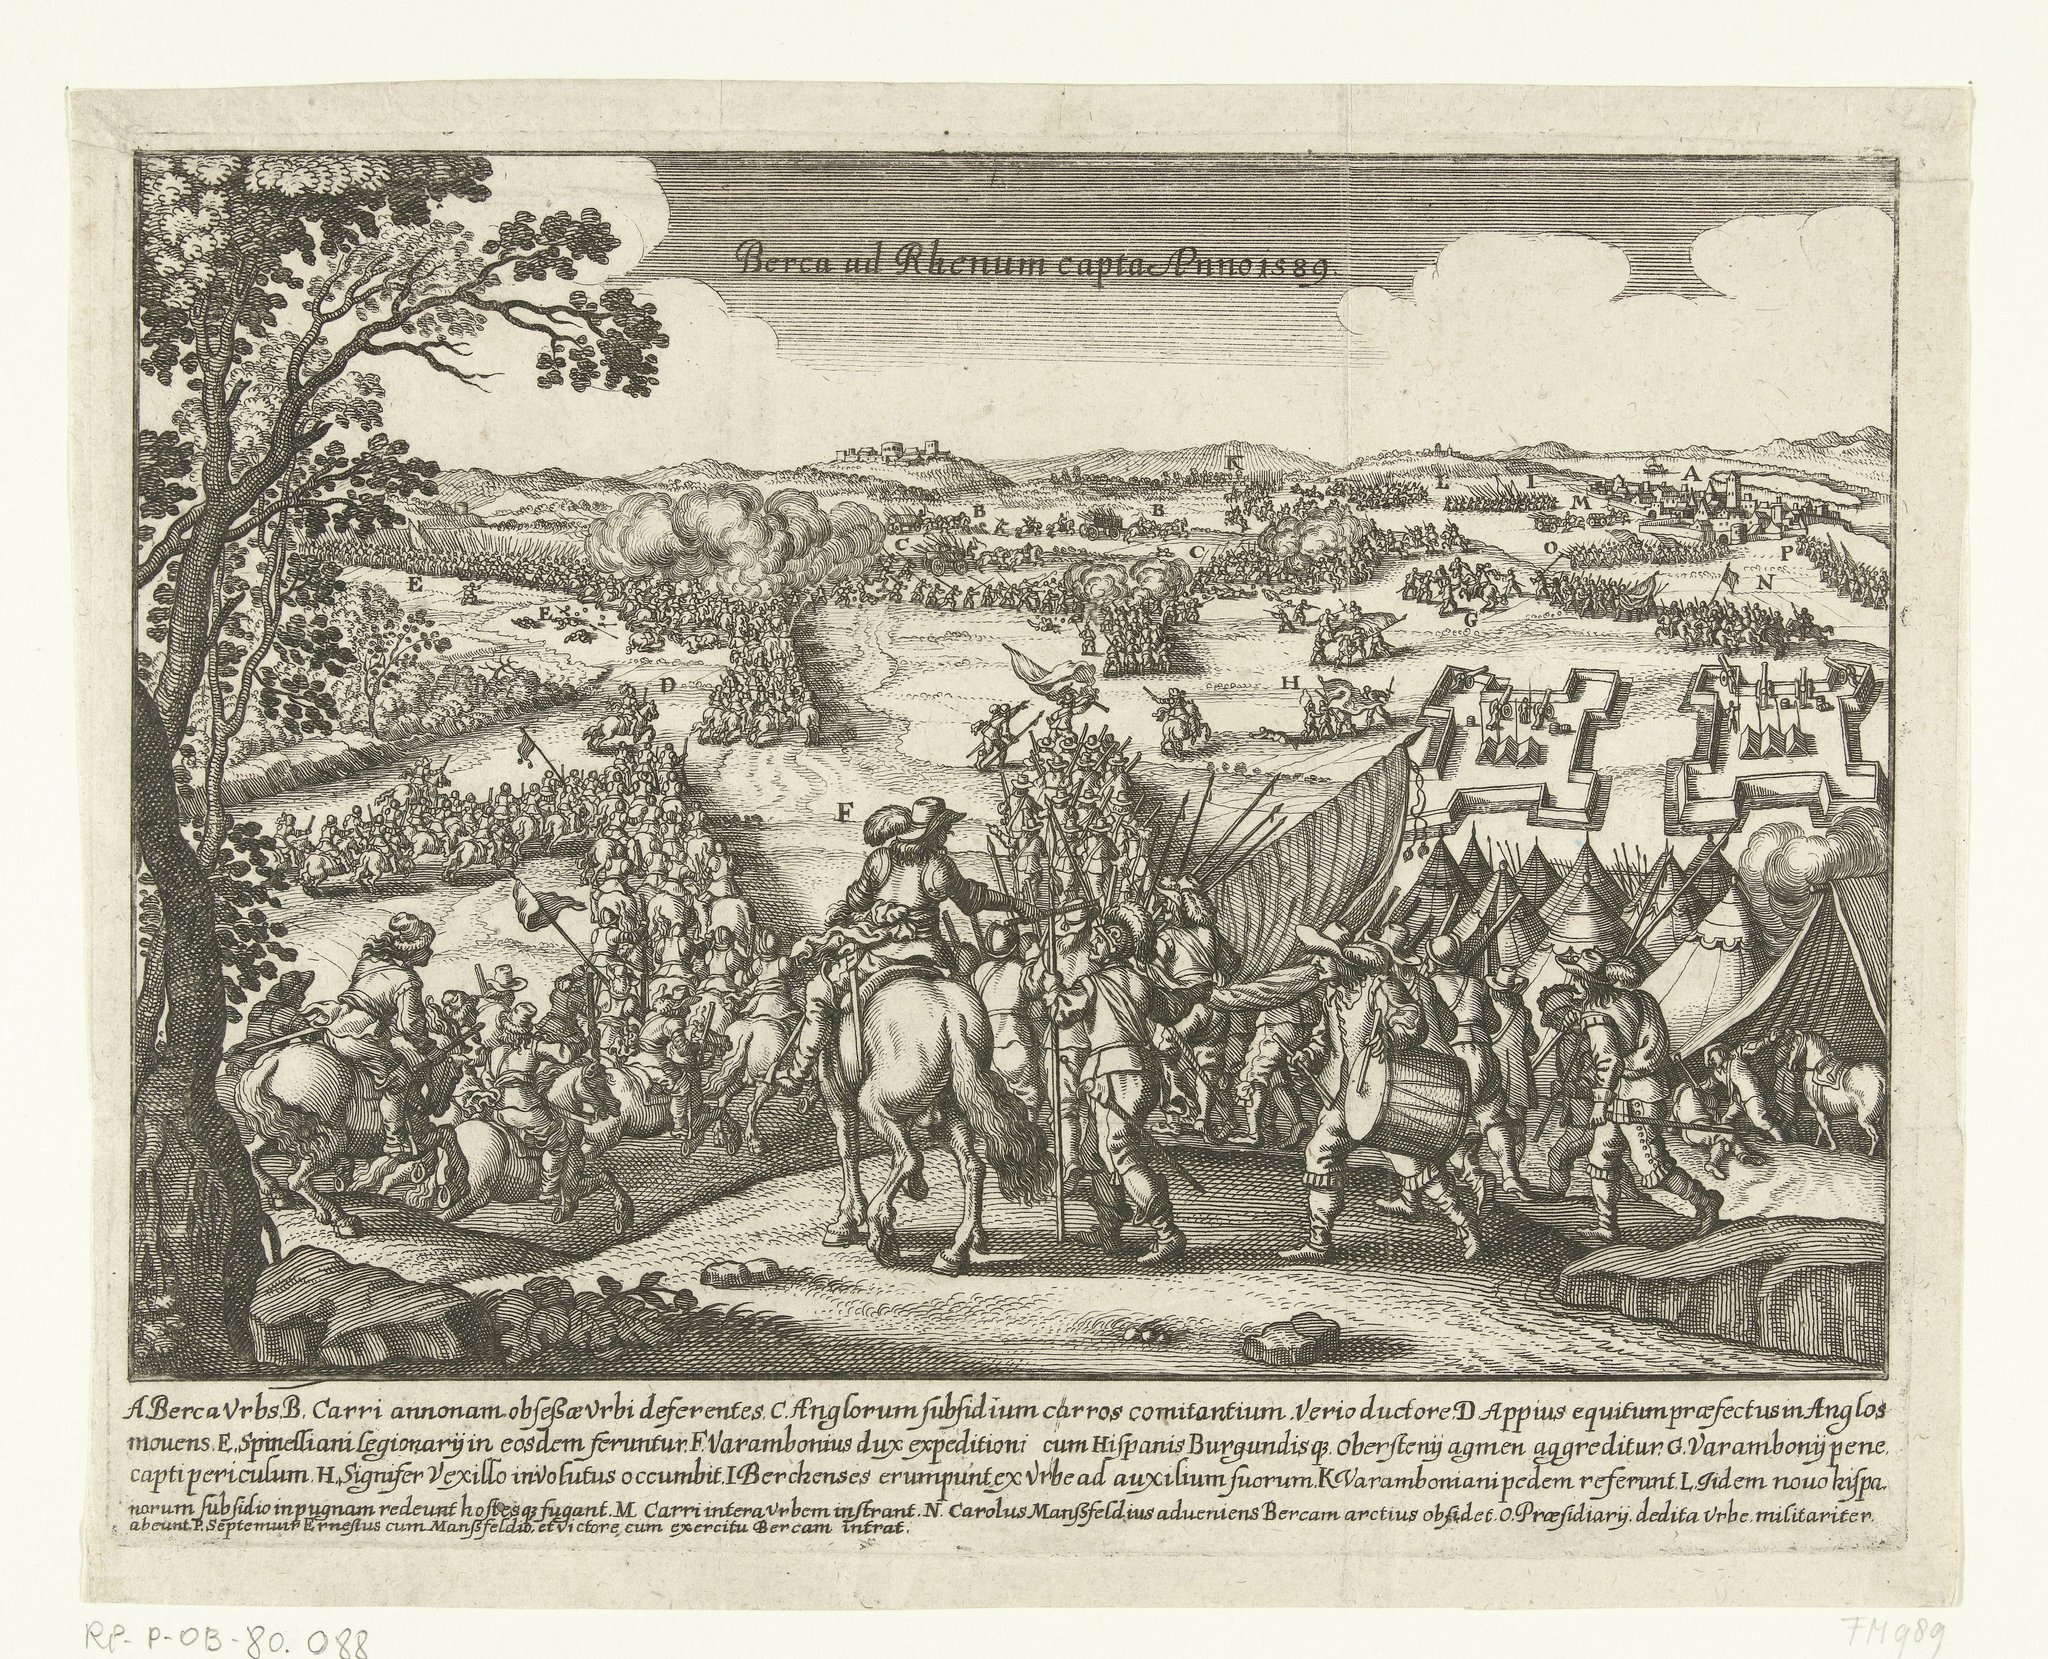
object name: history print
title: Inname van Rheinberg, 1590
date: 1649-1651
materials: paper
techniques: etching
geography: rome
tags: capture of city (after the siege)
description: Gebruikt als illustratie in: F. Strada, De Bello belgico decades duae auctiores et correctiores cum figuris encis prodeunt a Famiano Strada Soc: Jesu Romano Moguntiae 1651. Kopie naar de prent van J. Courtois in de oorspronkelijke editie van 1647, zie FMH 454A/28 en FMH 988.